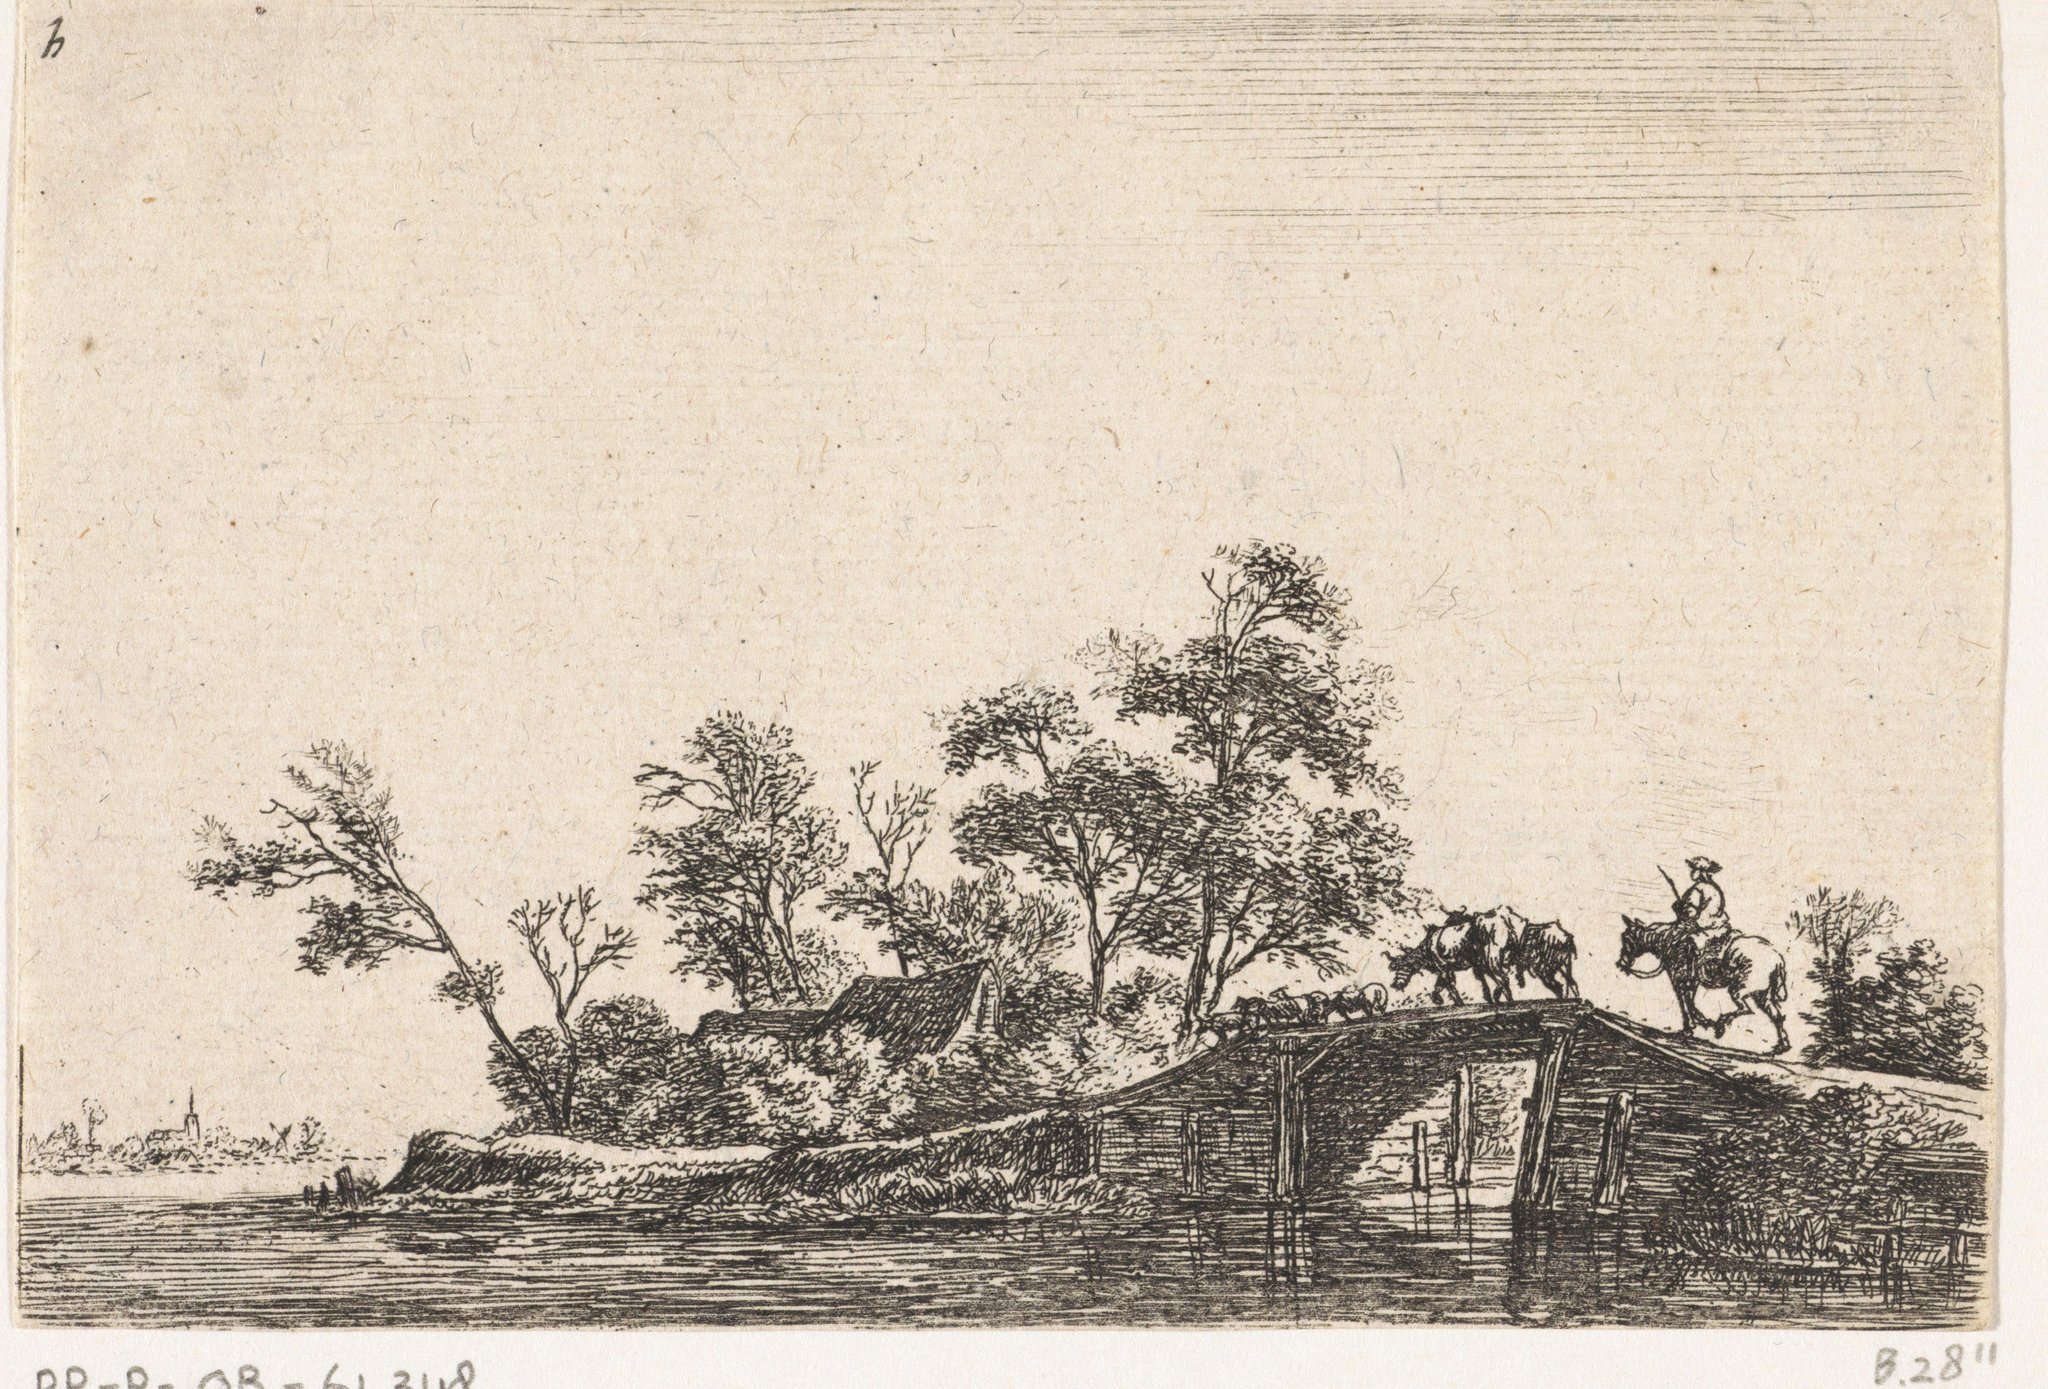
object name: print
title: Herder met vee op een houten brug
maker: anthonie waterloo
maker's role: draughtsman, painter, print maker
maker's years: 1609-1690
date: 1630-1663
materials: paper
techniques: etching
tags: herding, herdsman, herdswoman, shepherd, shepherdess, cowherd, etc., cattle, landscape with bridge, viaduct or aqueduct, landscapes with waters, waterscapes, seascapes (in the temperate zone), horse, farm or solitary house in landscape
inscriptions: collector's mark: Lugt 2228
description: Een houten brug leidt naar een huis, dat verscholen ligt tussen de bomen. Op de brug drijft een herder te paard vee voort. Linksboven is de letter h te zien.